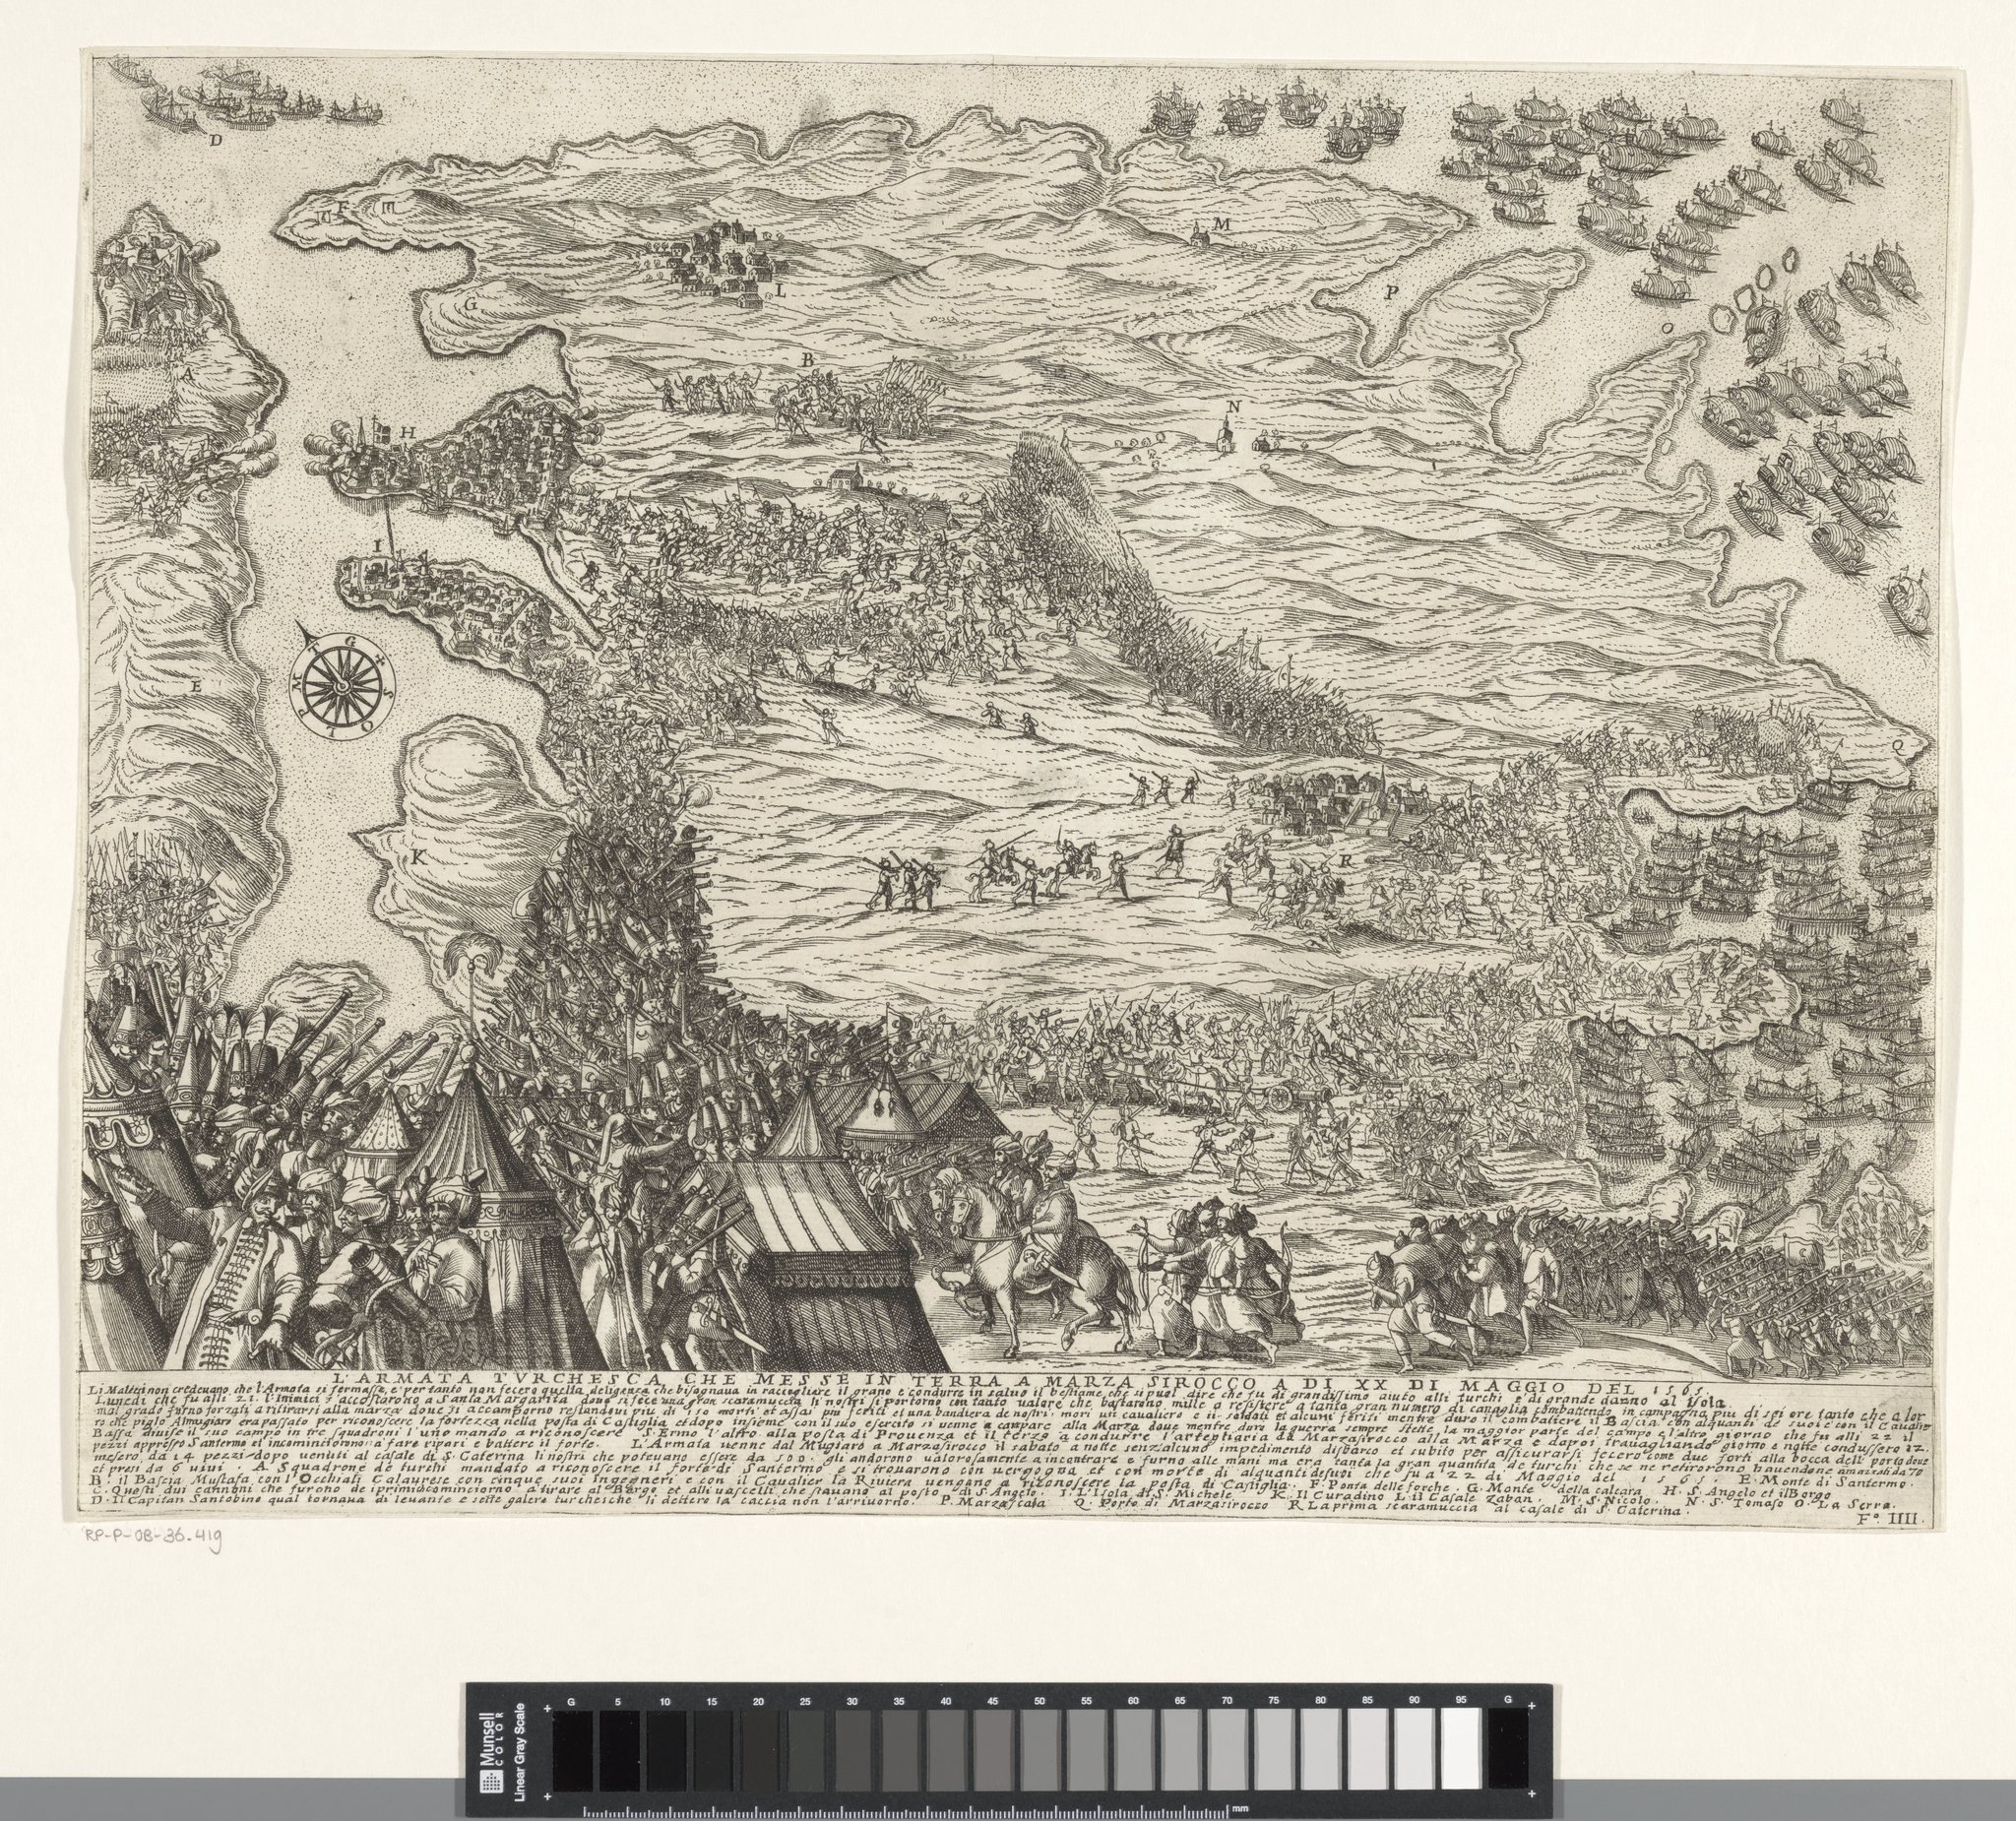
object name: print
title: L'armata Turchesca che messe in terra a marza sirocco a di XX di maggio del 1565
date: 1665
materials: paper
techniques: etching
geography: rome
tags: island, asiatic races and peoples: turks, battle (+ naval force), the soldier; the soldier's life, battle (+ land forces)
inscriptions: collector's mark: Lugt 2228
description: Het Turkse leger gaat aan land op Malta. Gezicht op Malta in vogelperspectief. Turkse soldaten gaan op land het gevecht aan met de Maltezer soldaten. Italiaanse tekst in ondermarge. Genummerd rechtsonder: Fo. IIII.